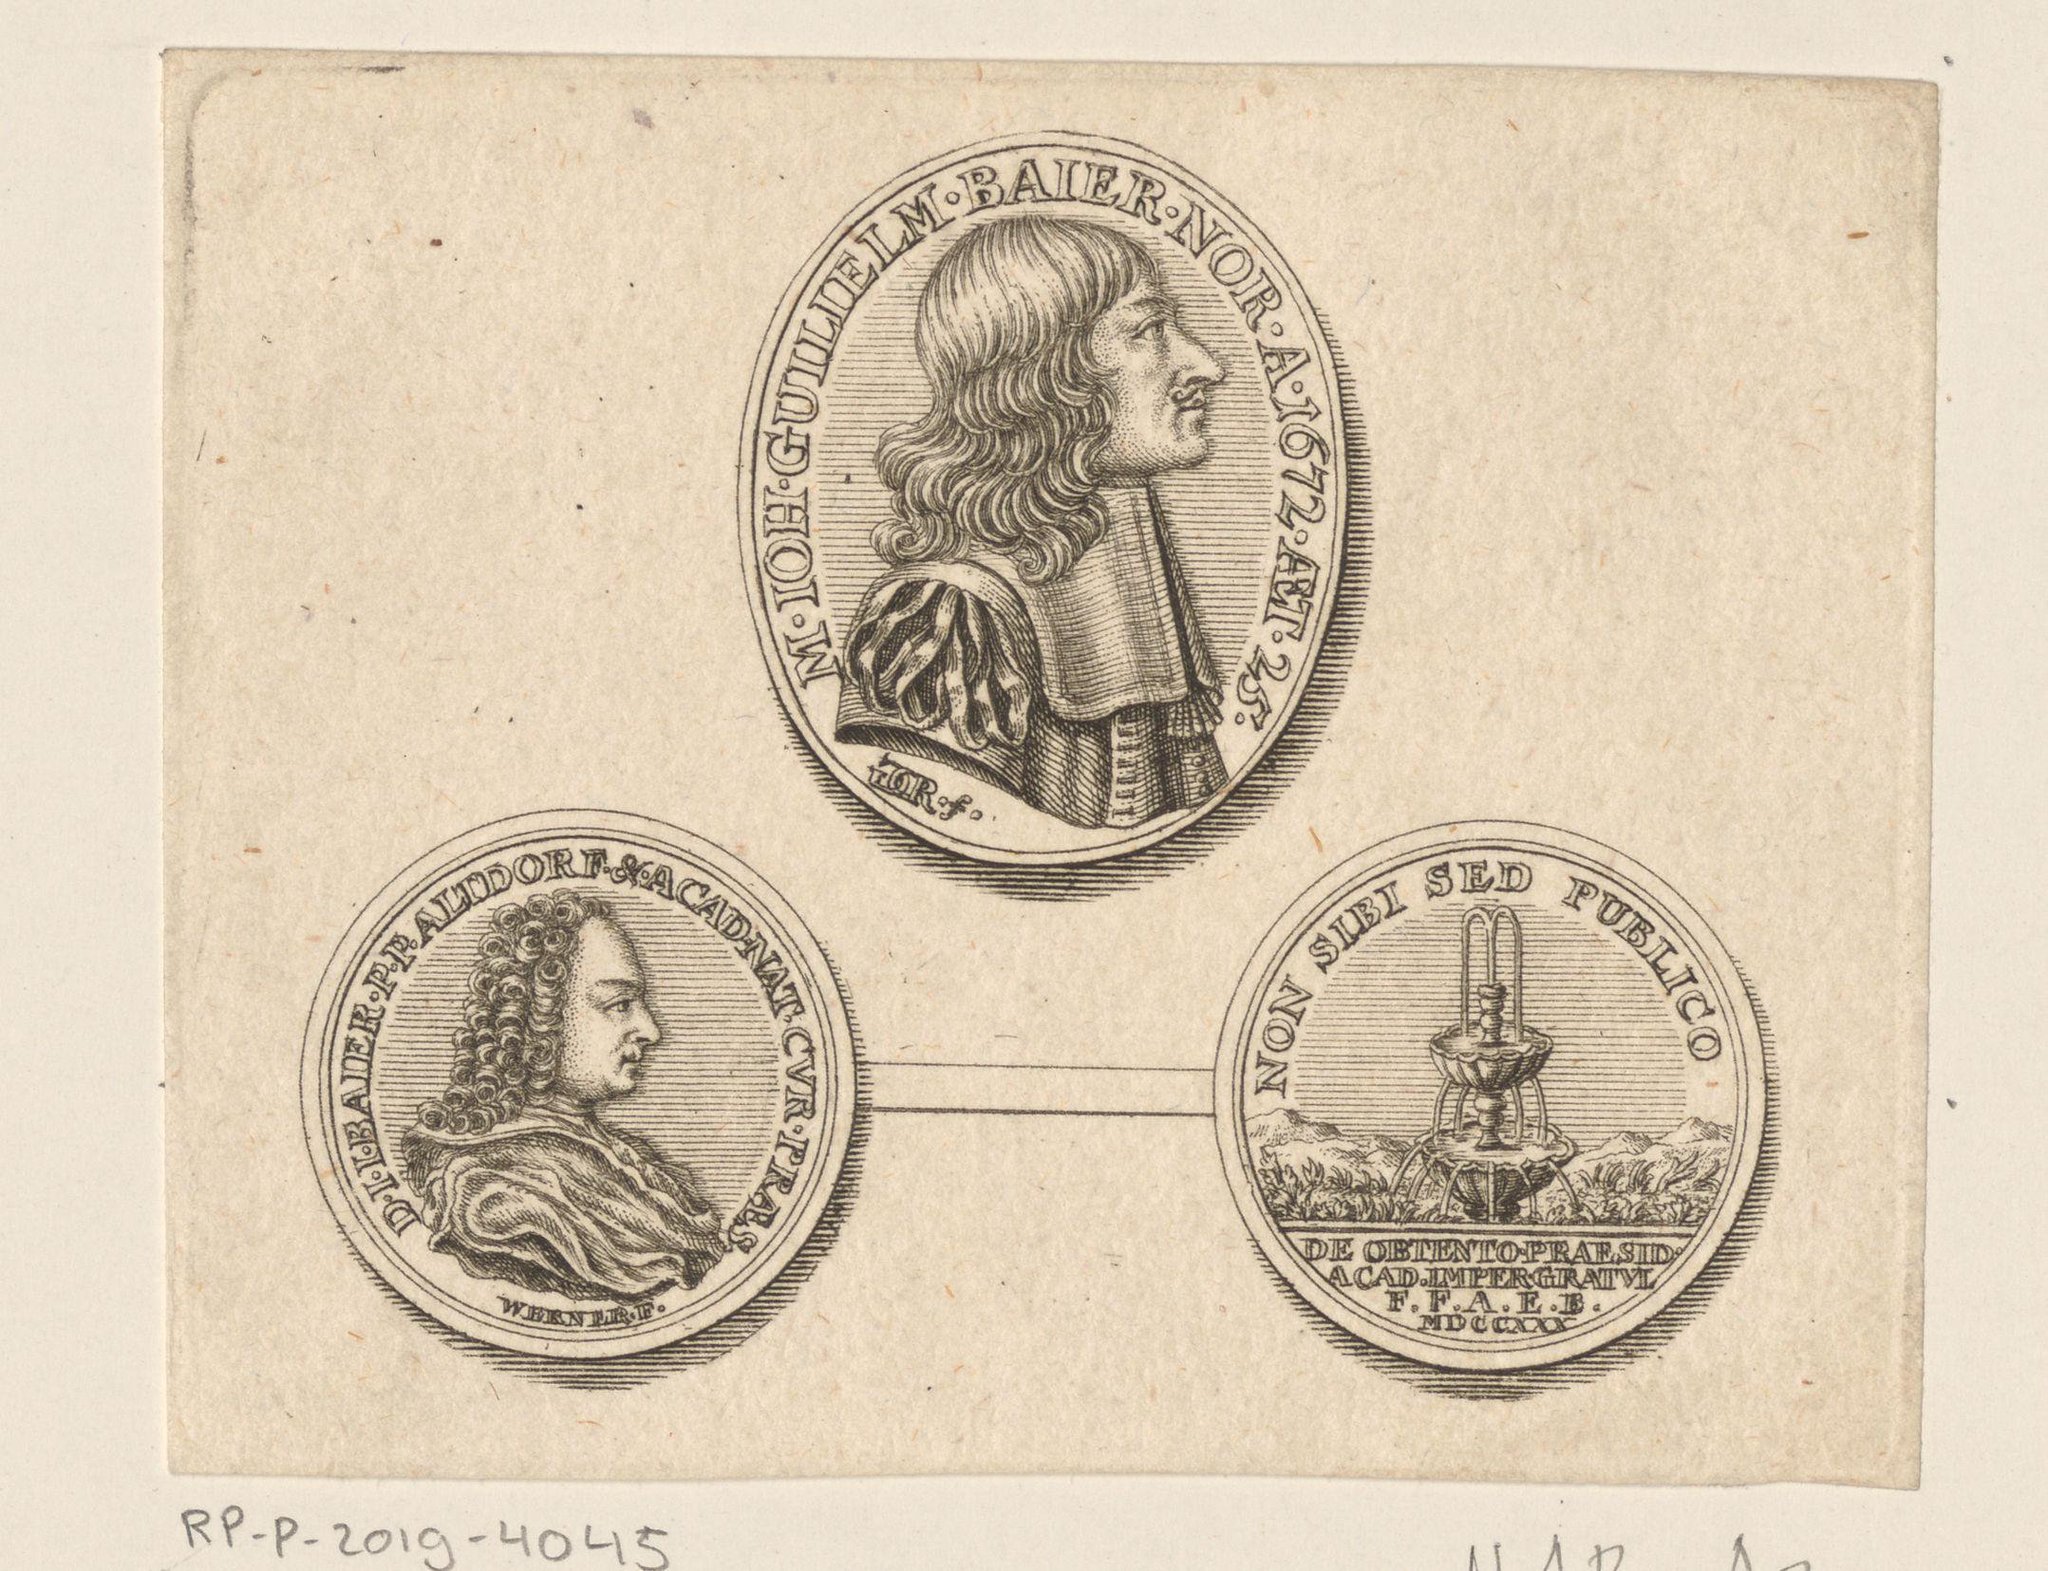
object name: print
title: Penningen met portretten van Johann Wilhelm Baier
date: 1750-1799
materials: paper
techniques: engraving, etching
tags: historical persons, memorial medal